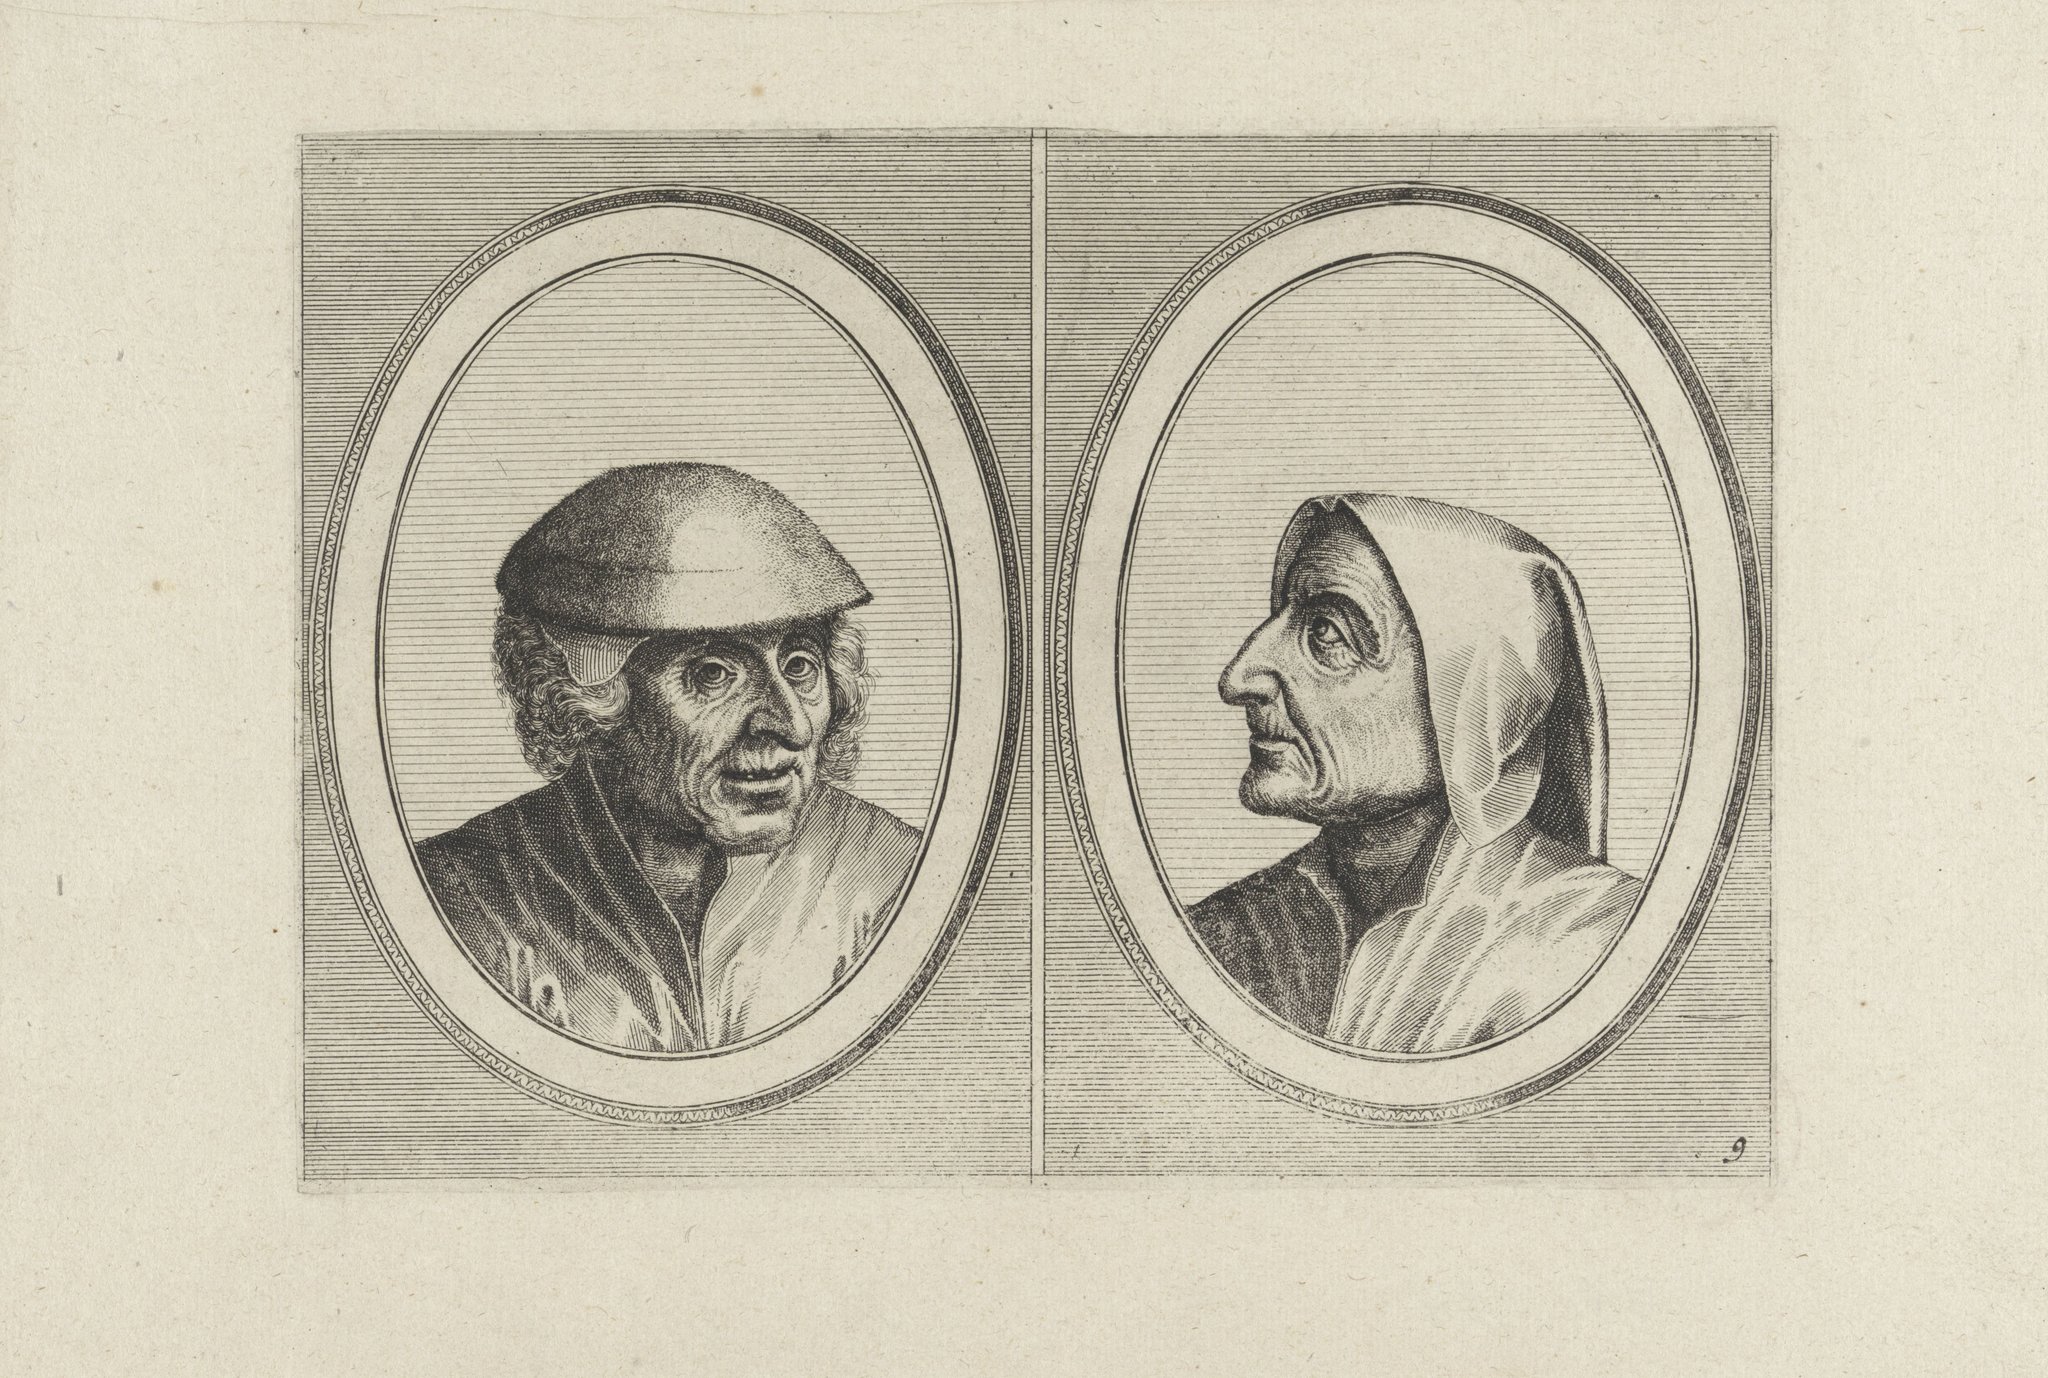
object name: print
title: Kees Geldt-sack en Kaarighe Truy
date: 1612-1652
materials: paper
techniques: engraving, etching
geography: amsterdam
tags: head-gear, farmers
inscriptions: collector's mark: Lugt 700, collector's mark: Lugt 240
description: Prent uit een serie van 36 prenten met koppen van boeren en boerinnen.